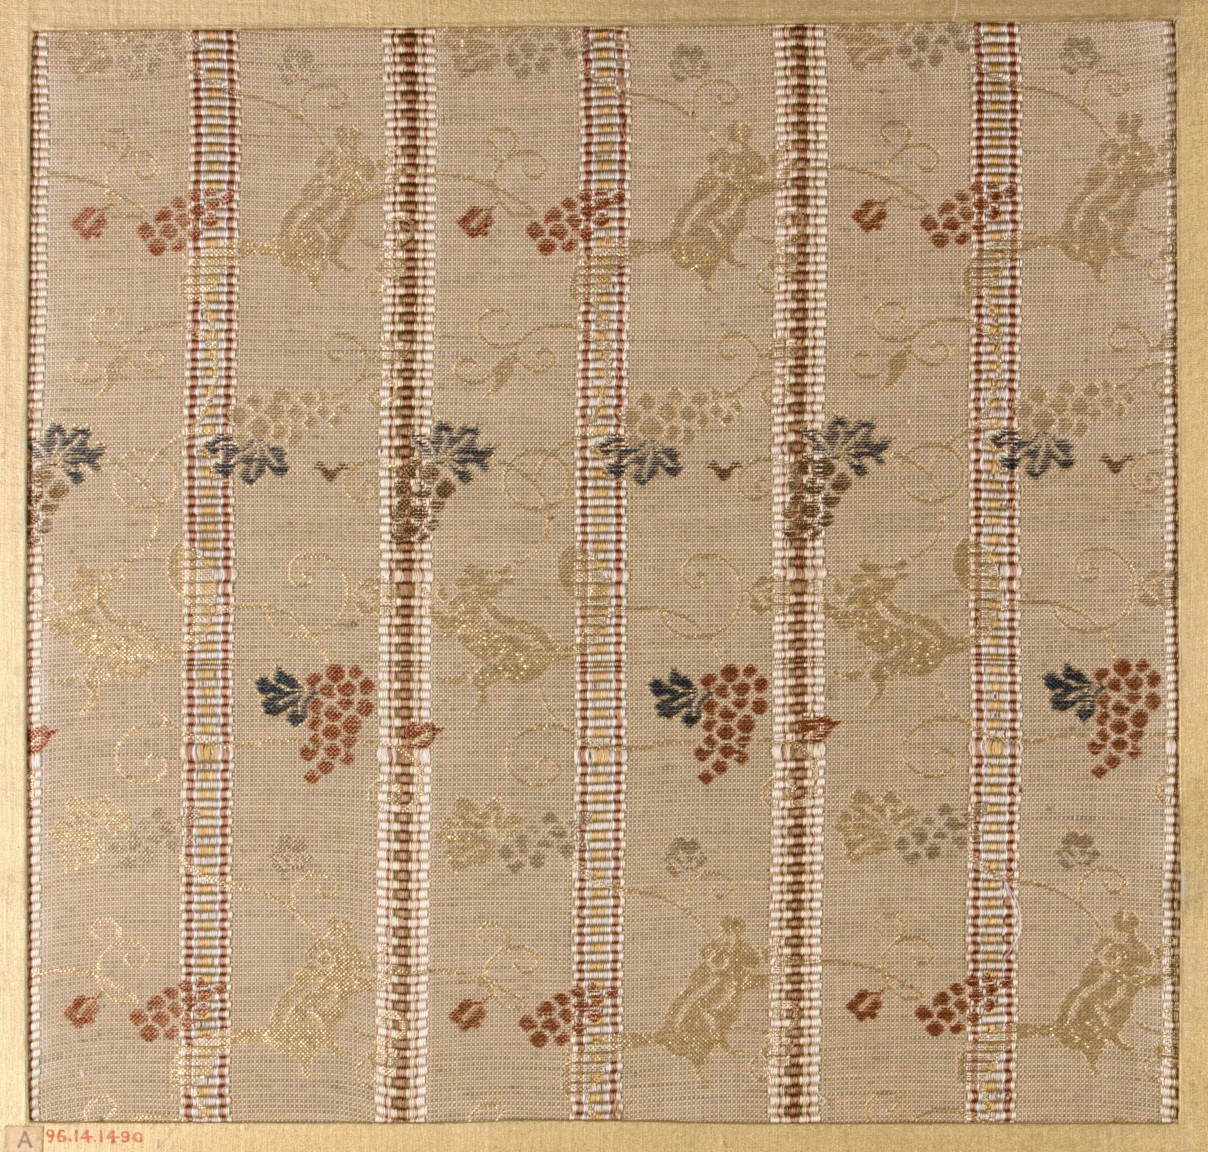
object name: piece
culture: japanese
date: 1701-1900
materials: silk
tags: grapes,squirrels